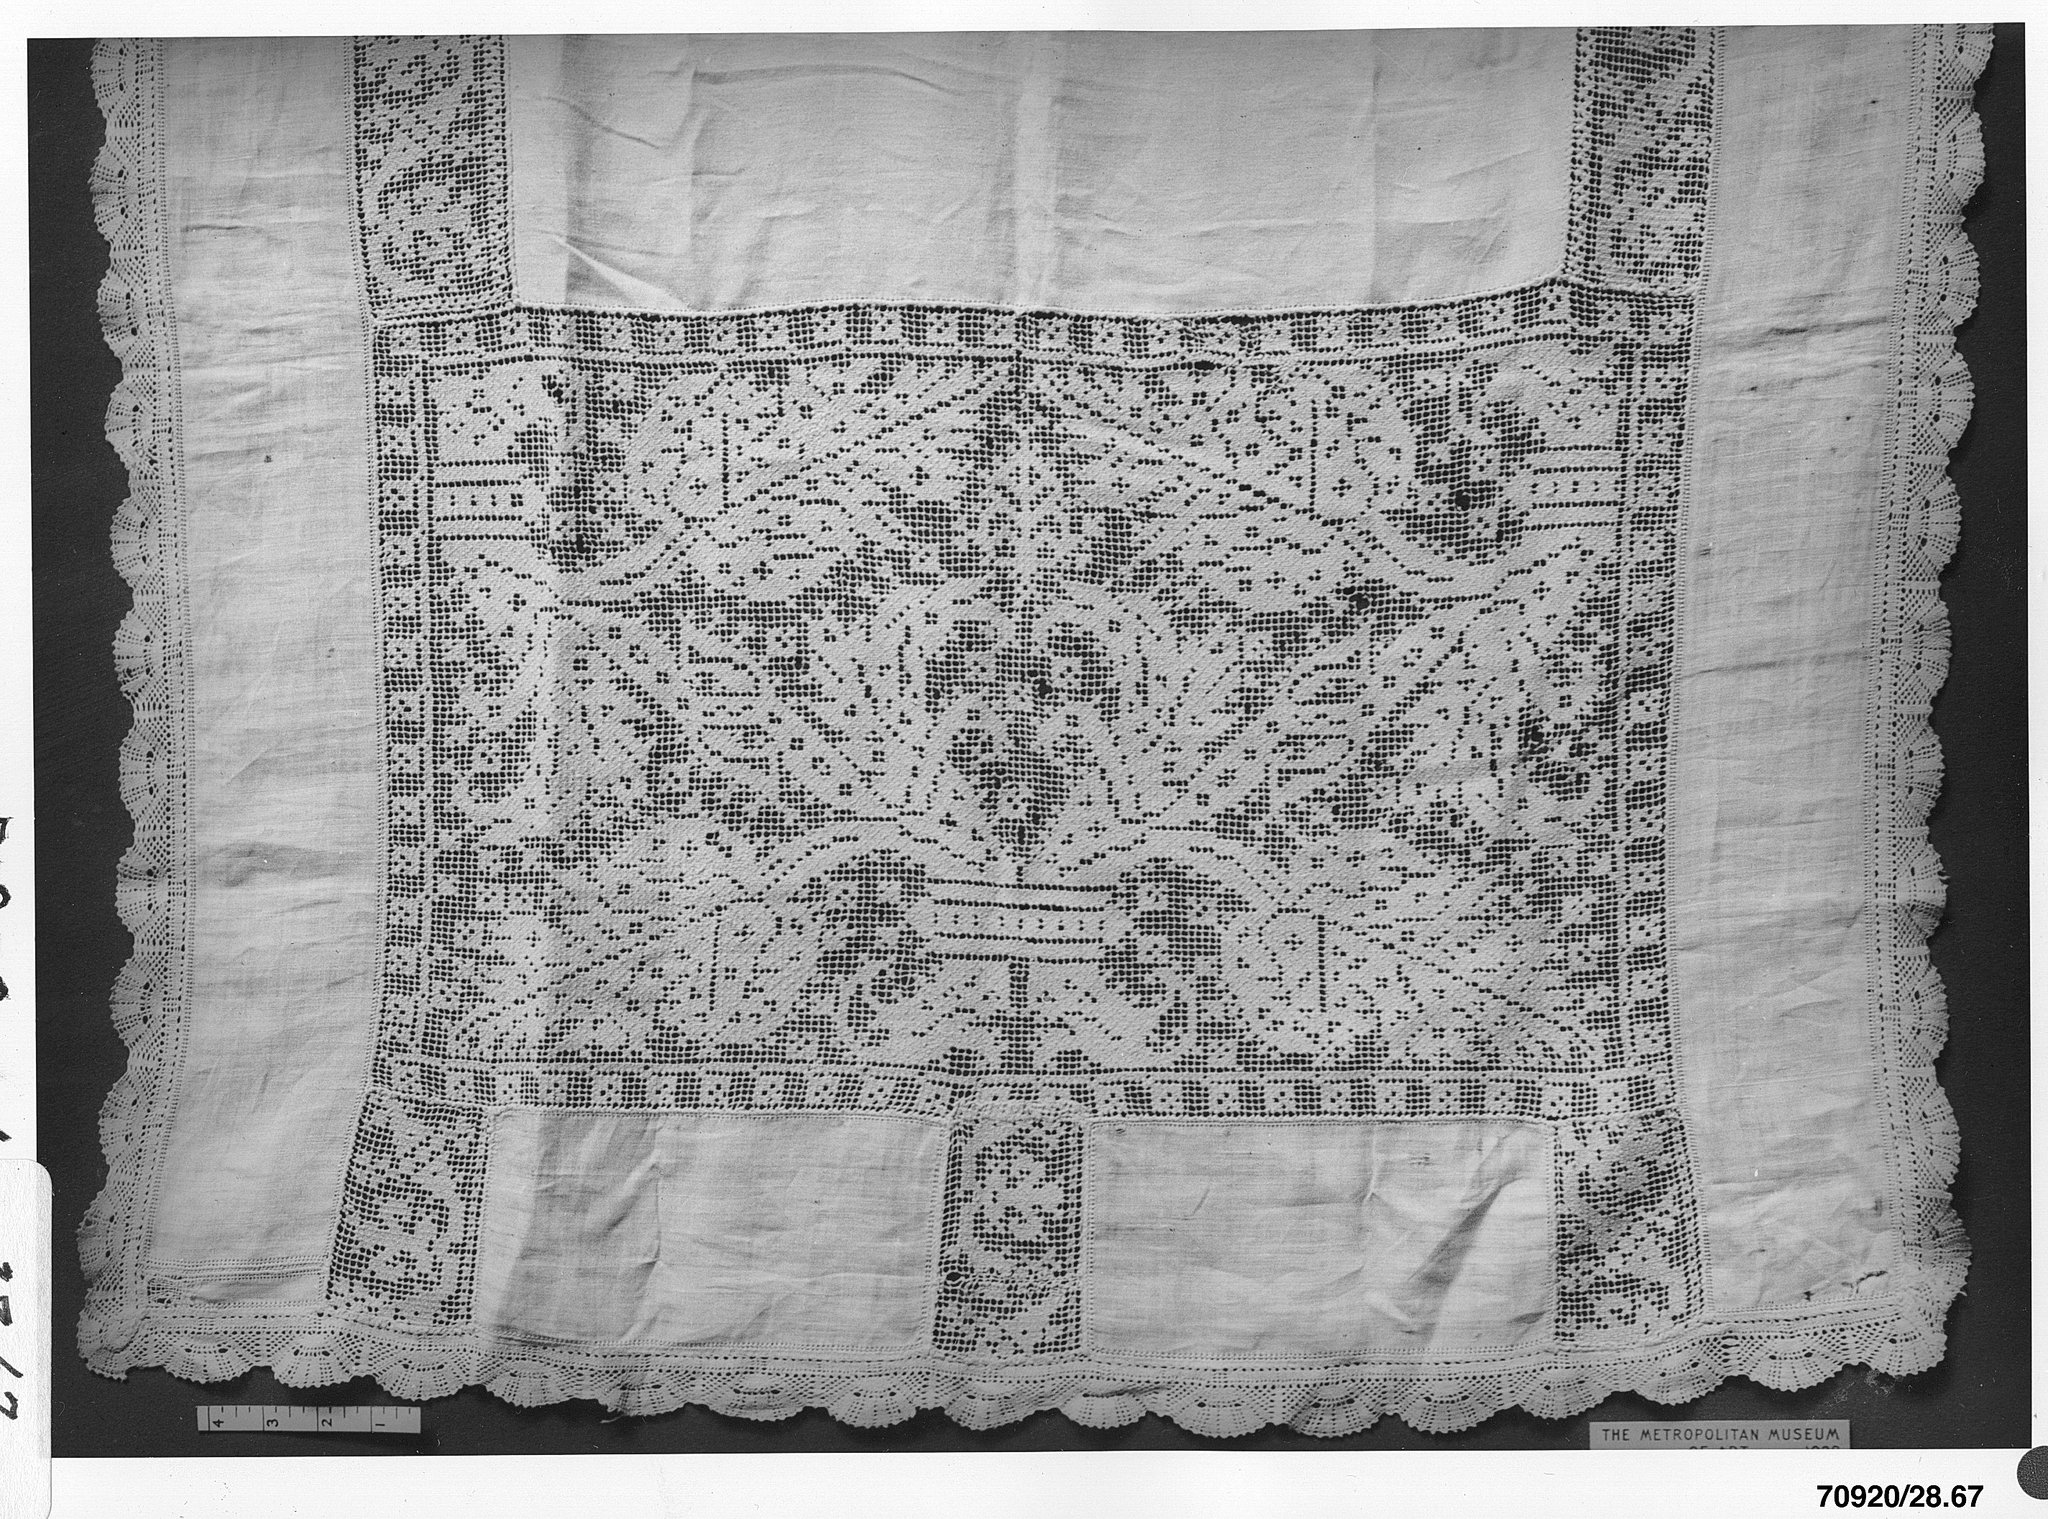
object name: altar cloth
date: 1601-1700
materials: linen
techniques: embroidery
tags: leaves